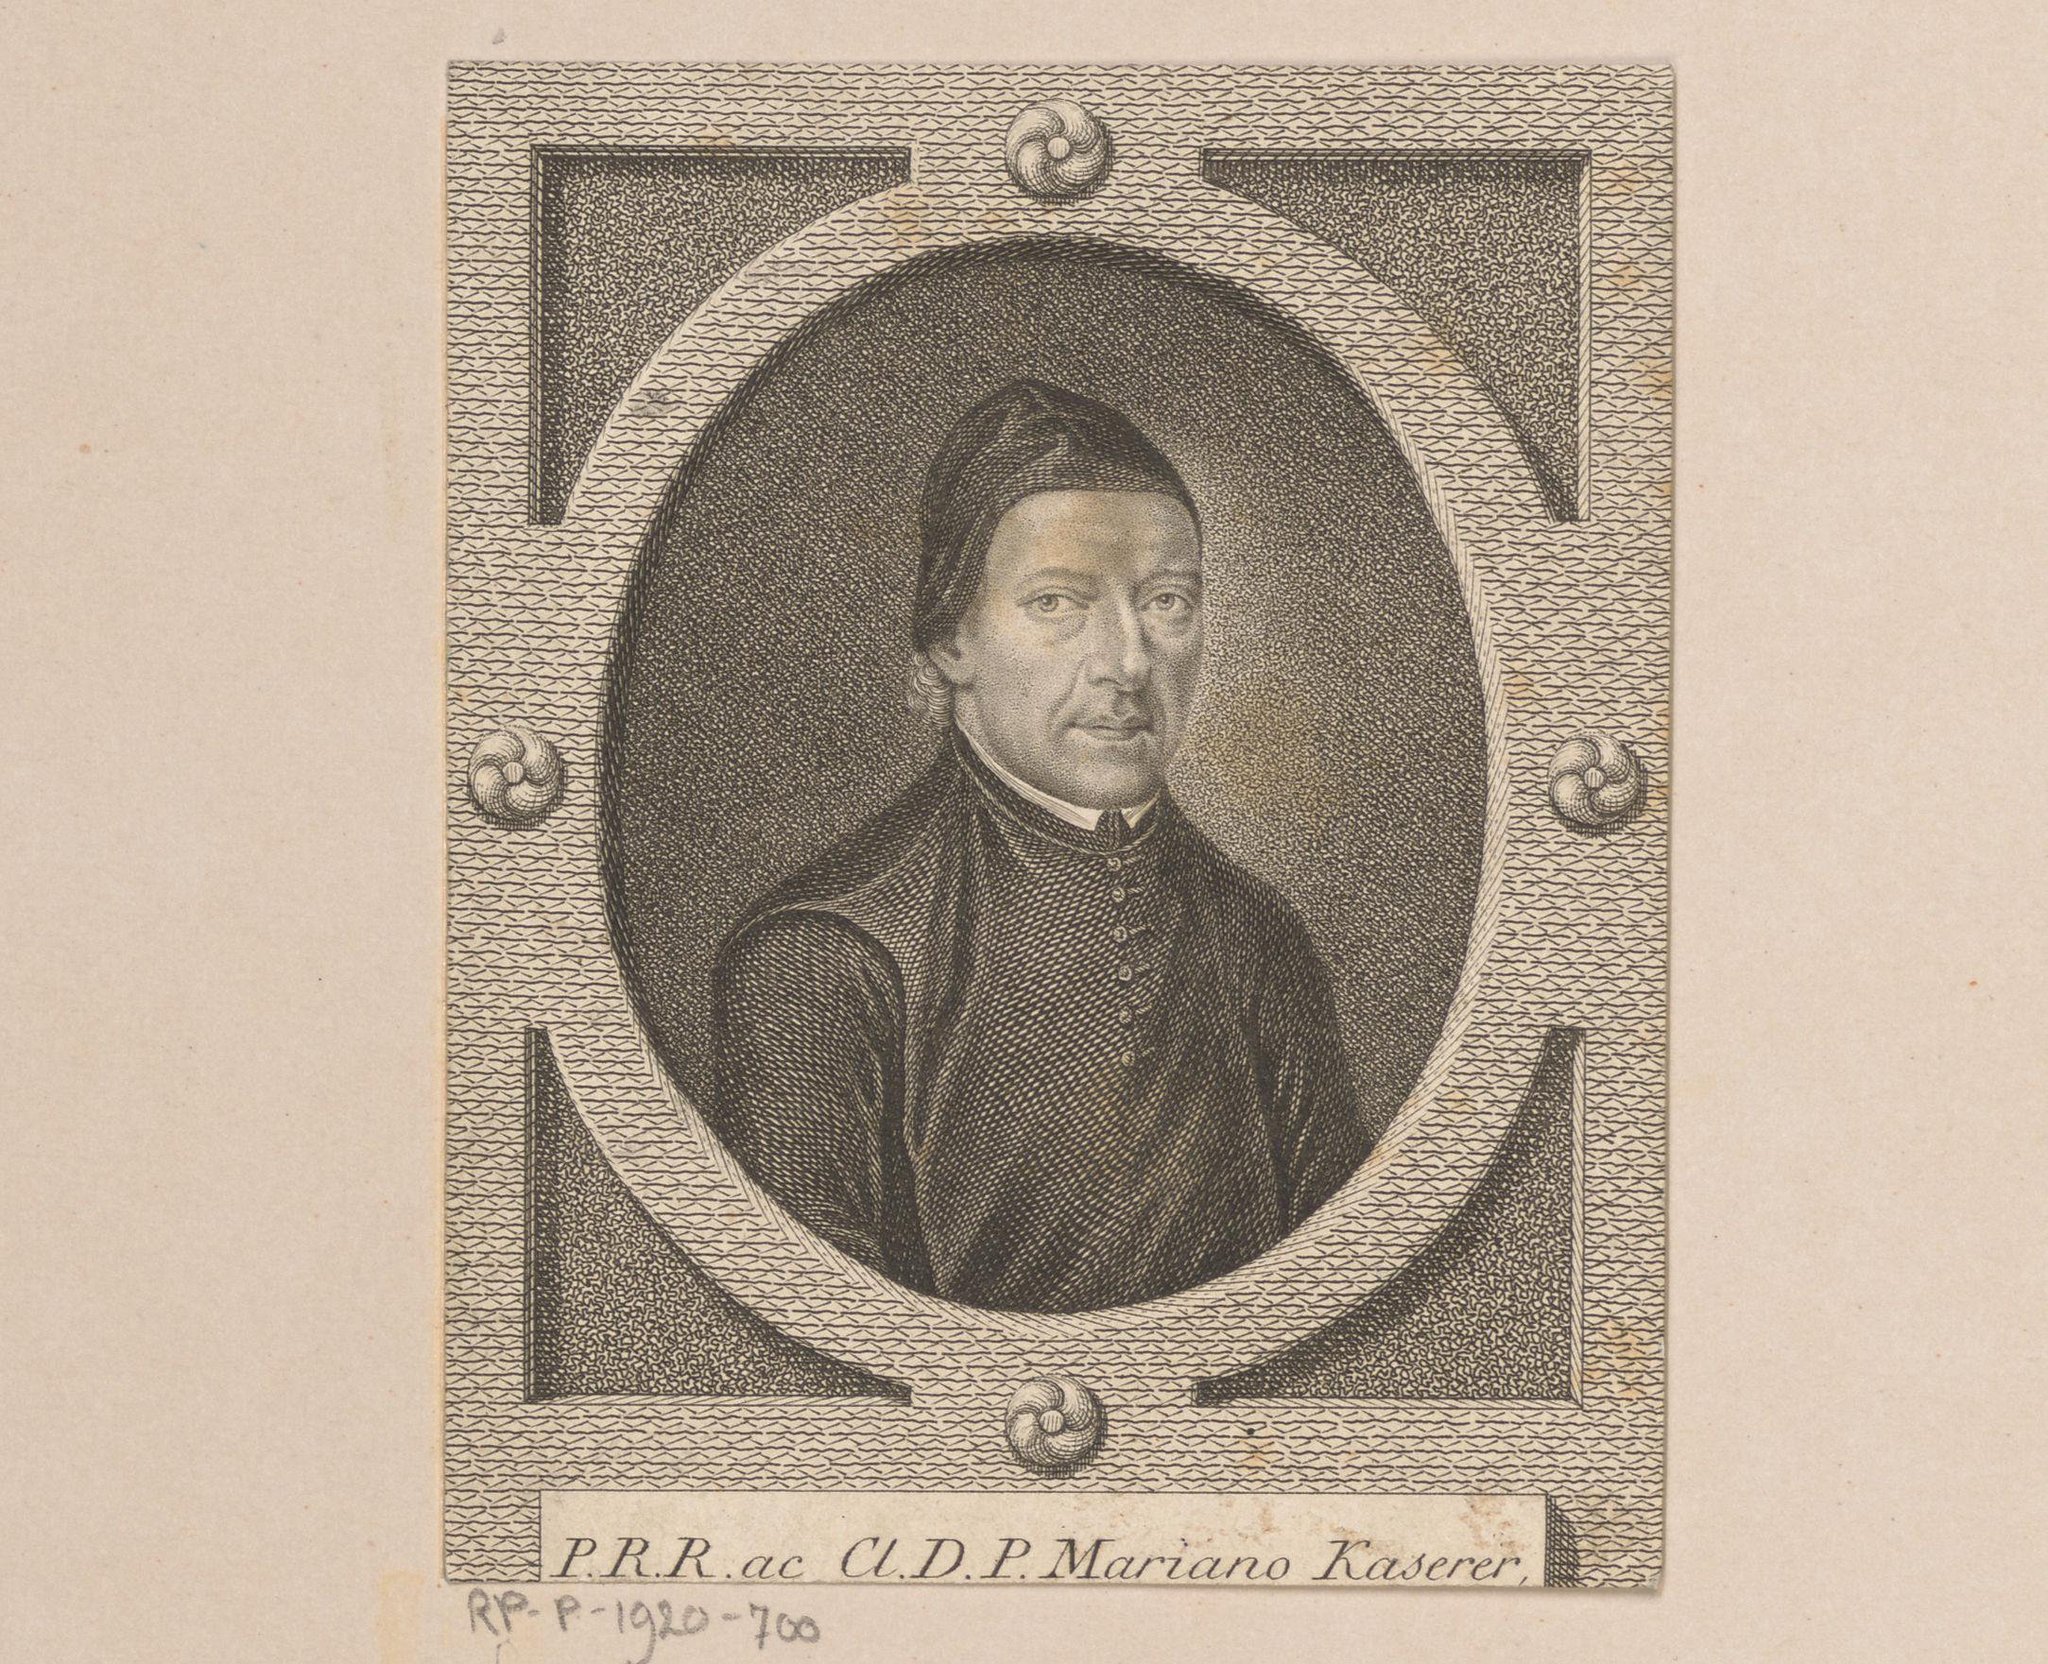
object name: print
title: Portret van Marian Kaserer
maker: Anonymous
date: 1774-1849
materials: paper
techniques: engraving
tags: historical persons, monk(s), friar(s)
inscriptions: collector's mark: Lugt 2228